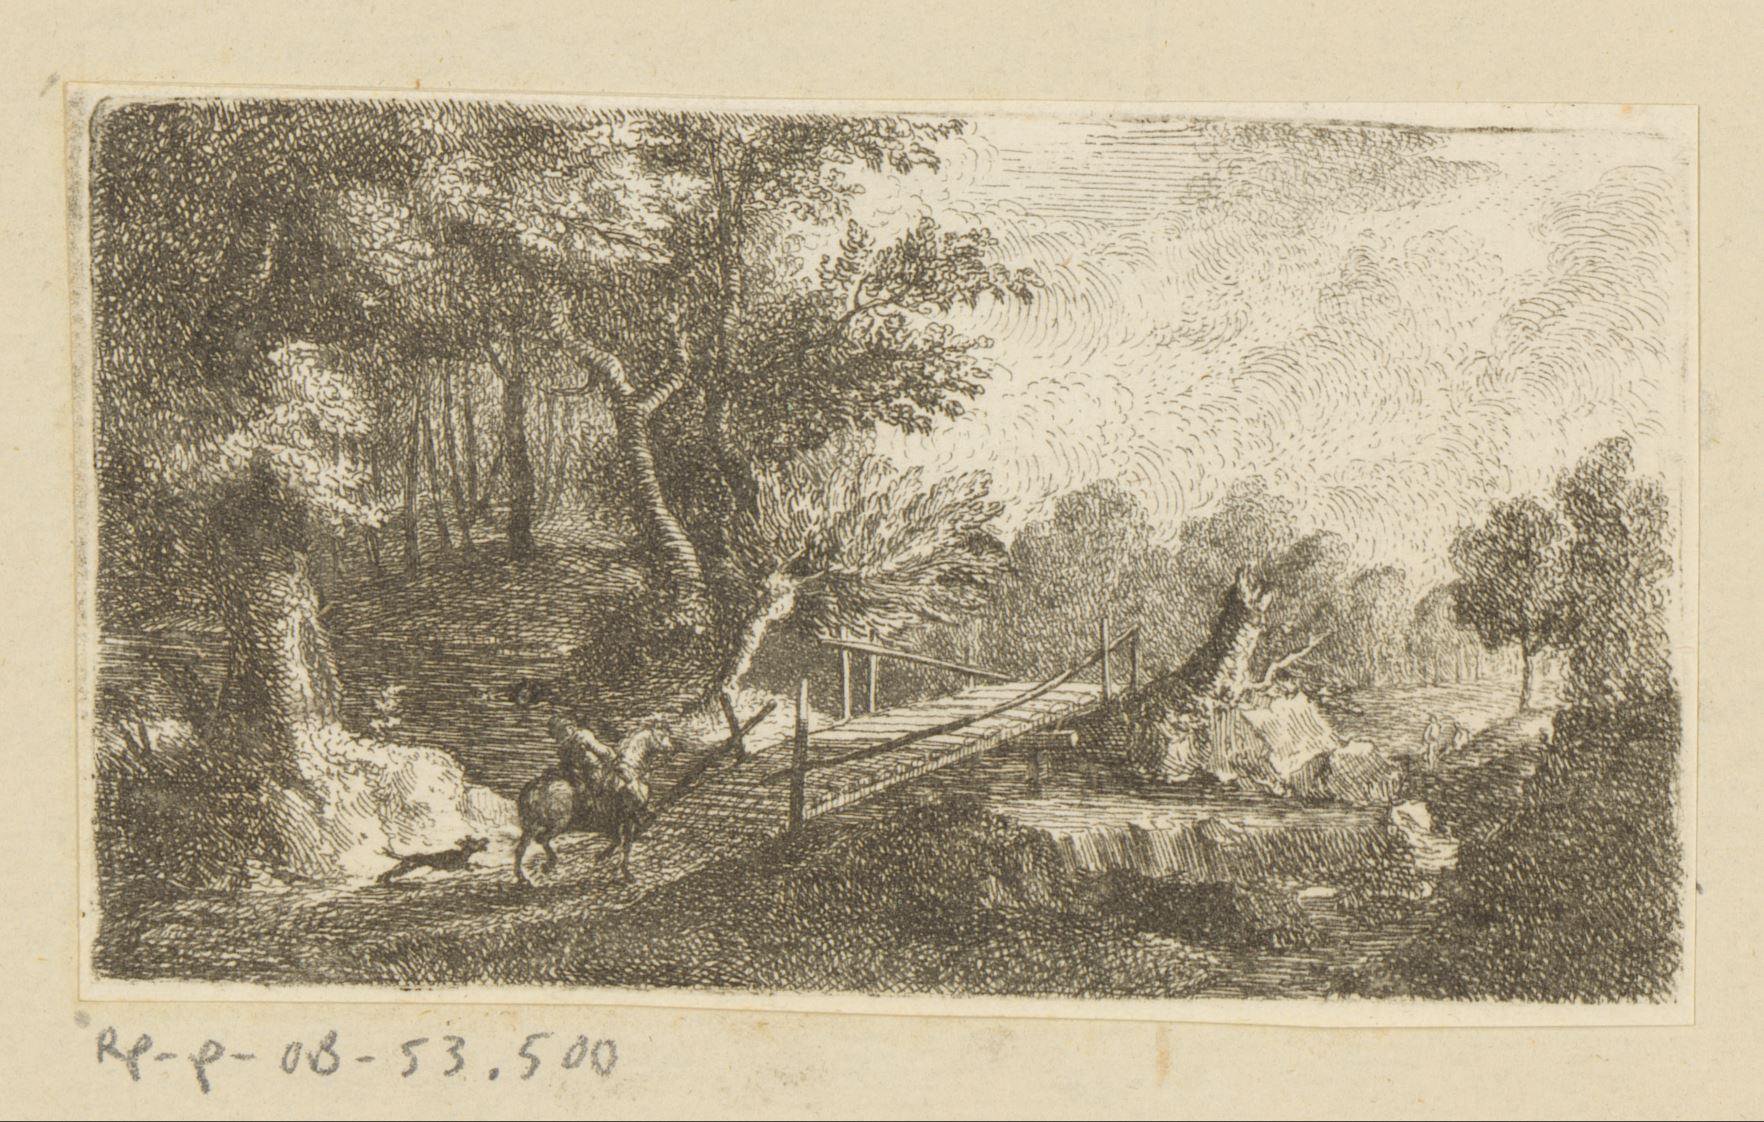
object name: print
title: Ruiter bij houten brug in bos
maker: johann andreas benjamin nothnagel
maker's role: print maker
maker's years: 1729-1804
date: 1739-1804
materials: paper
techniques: etching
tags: landscapes with waters, waterscapes, seascapes (in the temperate zone)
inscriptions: collector's mark: Lugt 240